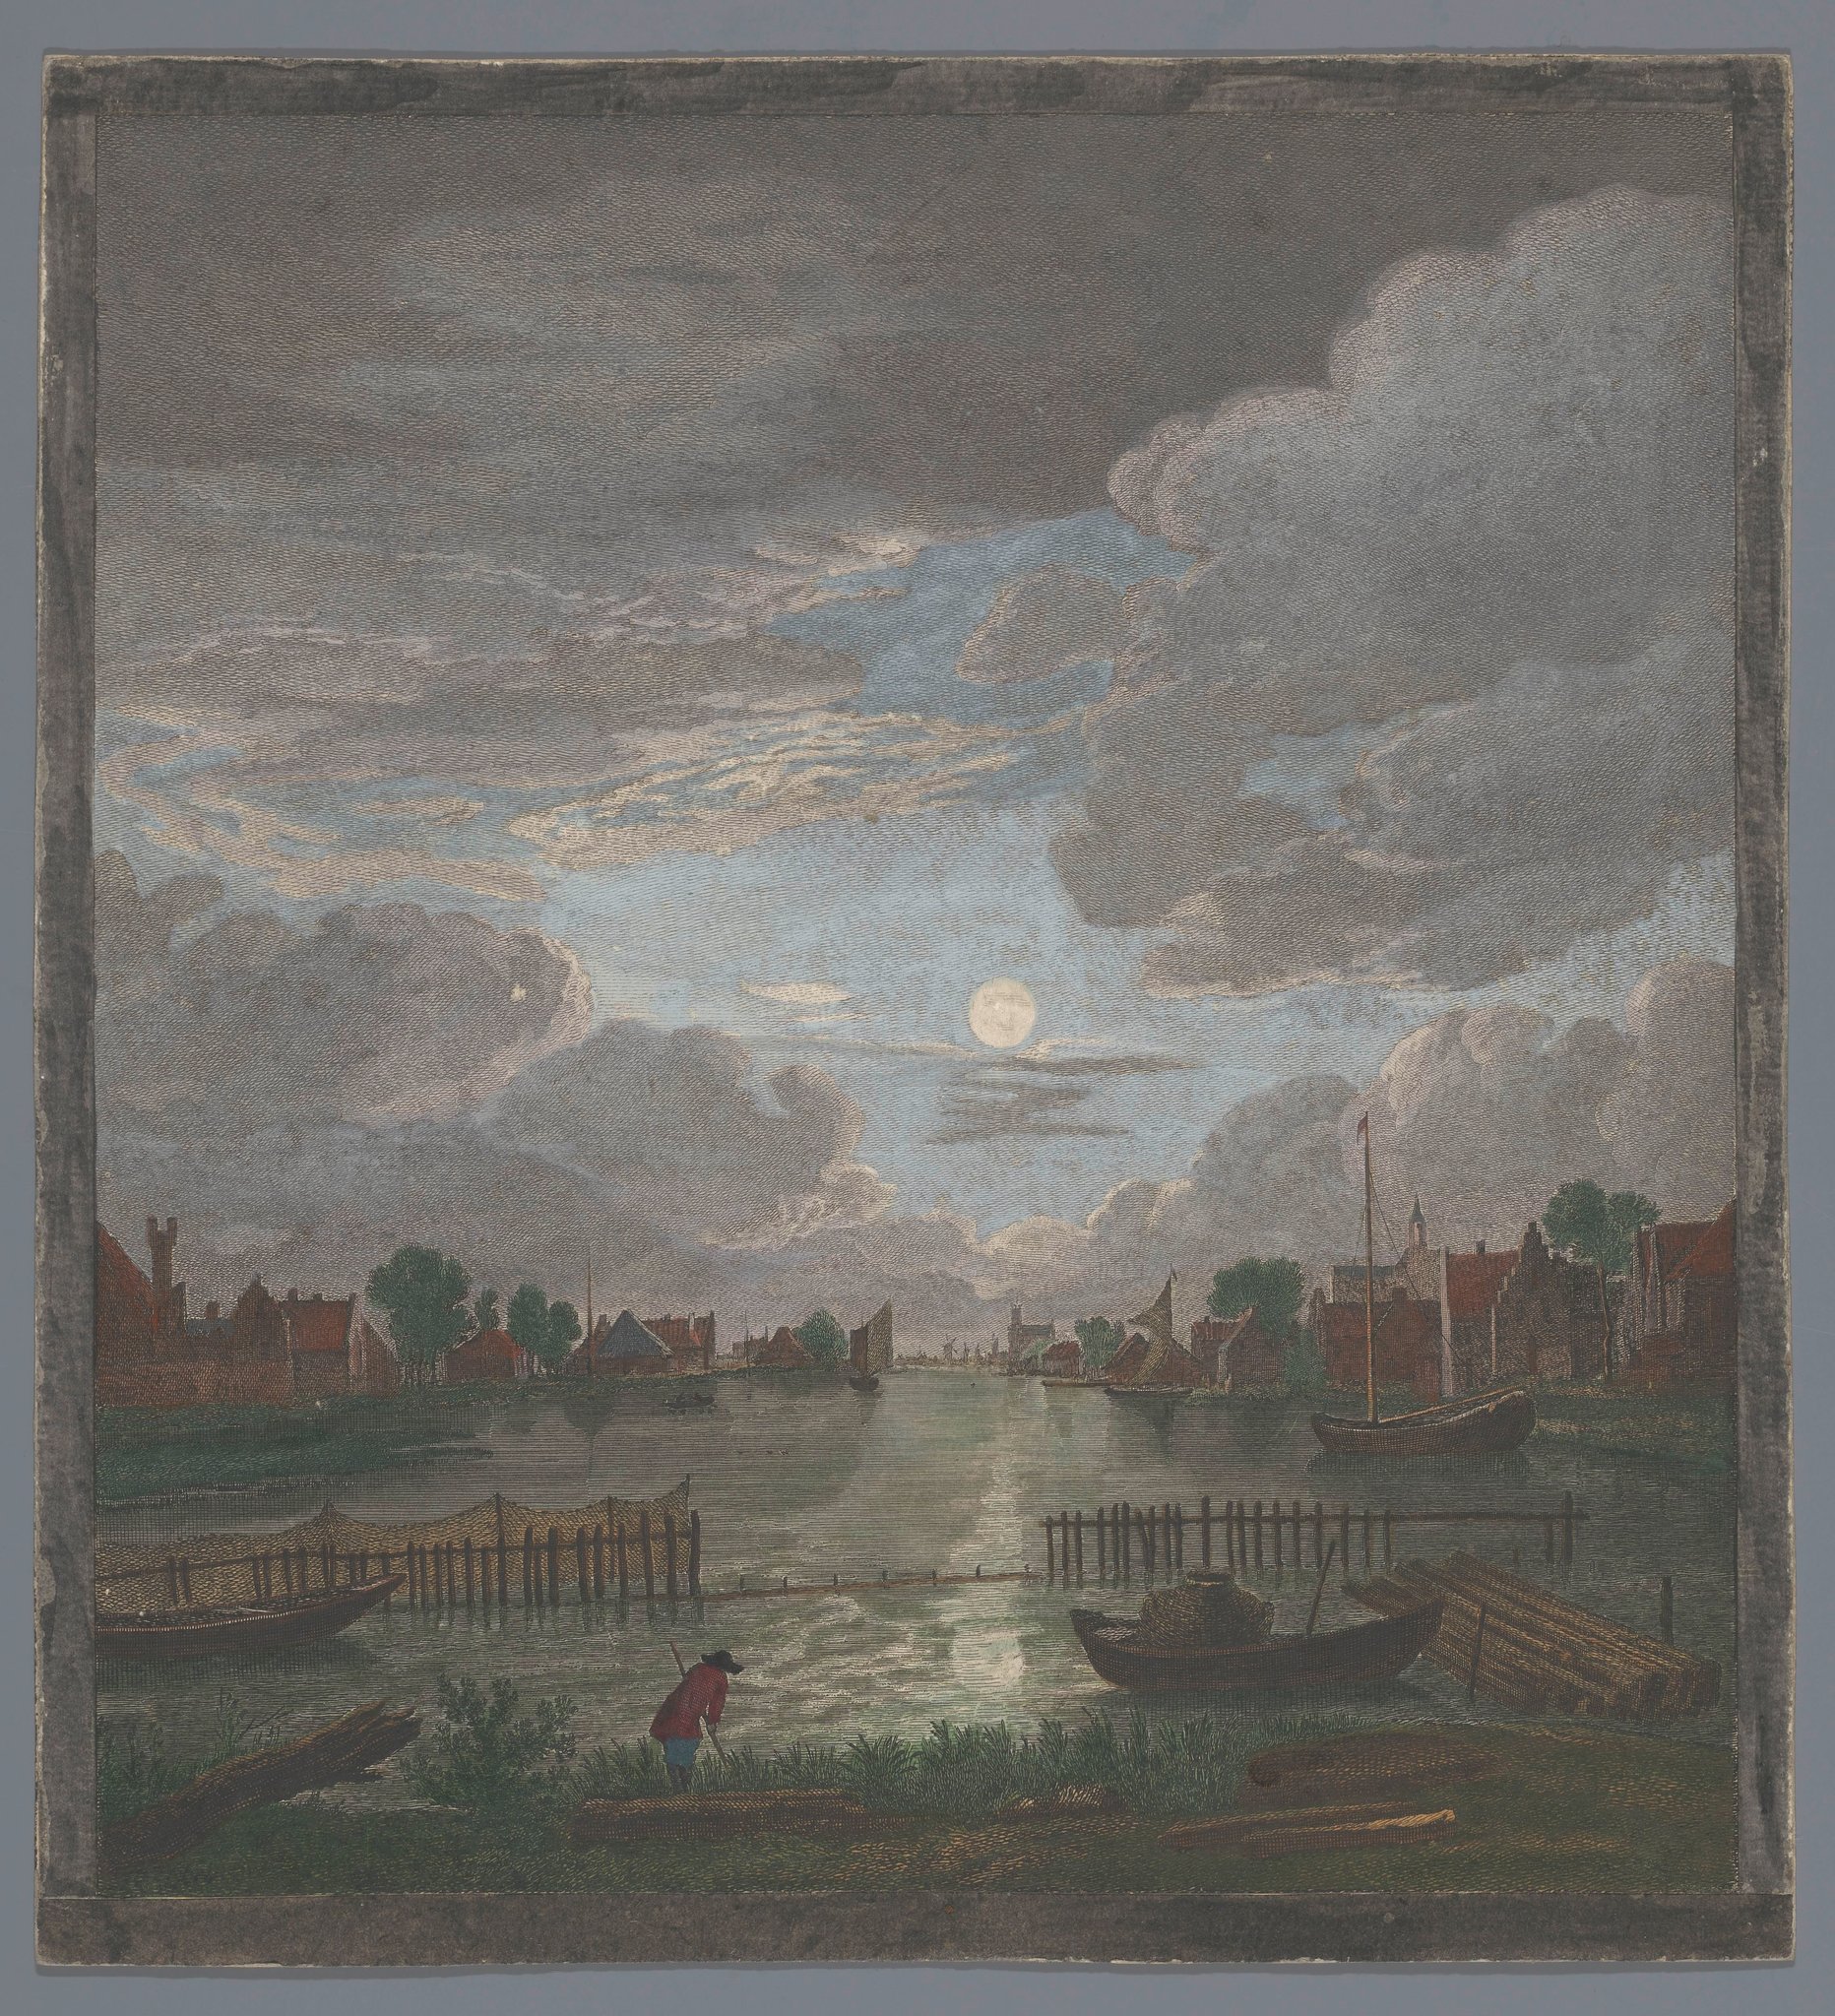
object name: opticaprent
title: Vûe du canal proche de Haerlem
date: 1753-1797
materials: cardboard, paper, watercolor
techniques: brush, etching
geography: paris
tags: sailing-ship, sailing-boat, moonlight, rowing-boat, canoe, etc., civic architecture; edifices; dwellings, canal (+ landscape with figures, staffage), haarlem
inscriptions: collector's mark: Lugt 2233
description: Aan het water staan huizen en op het water liggen schepen en boten. Op de voorgrond staat een man met een stok in het water.